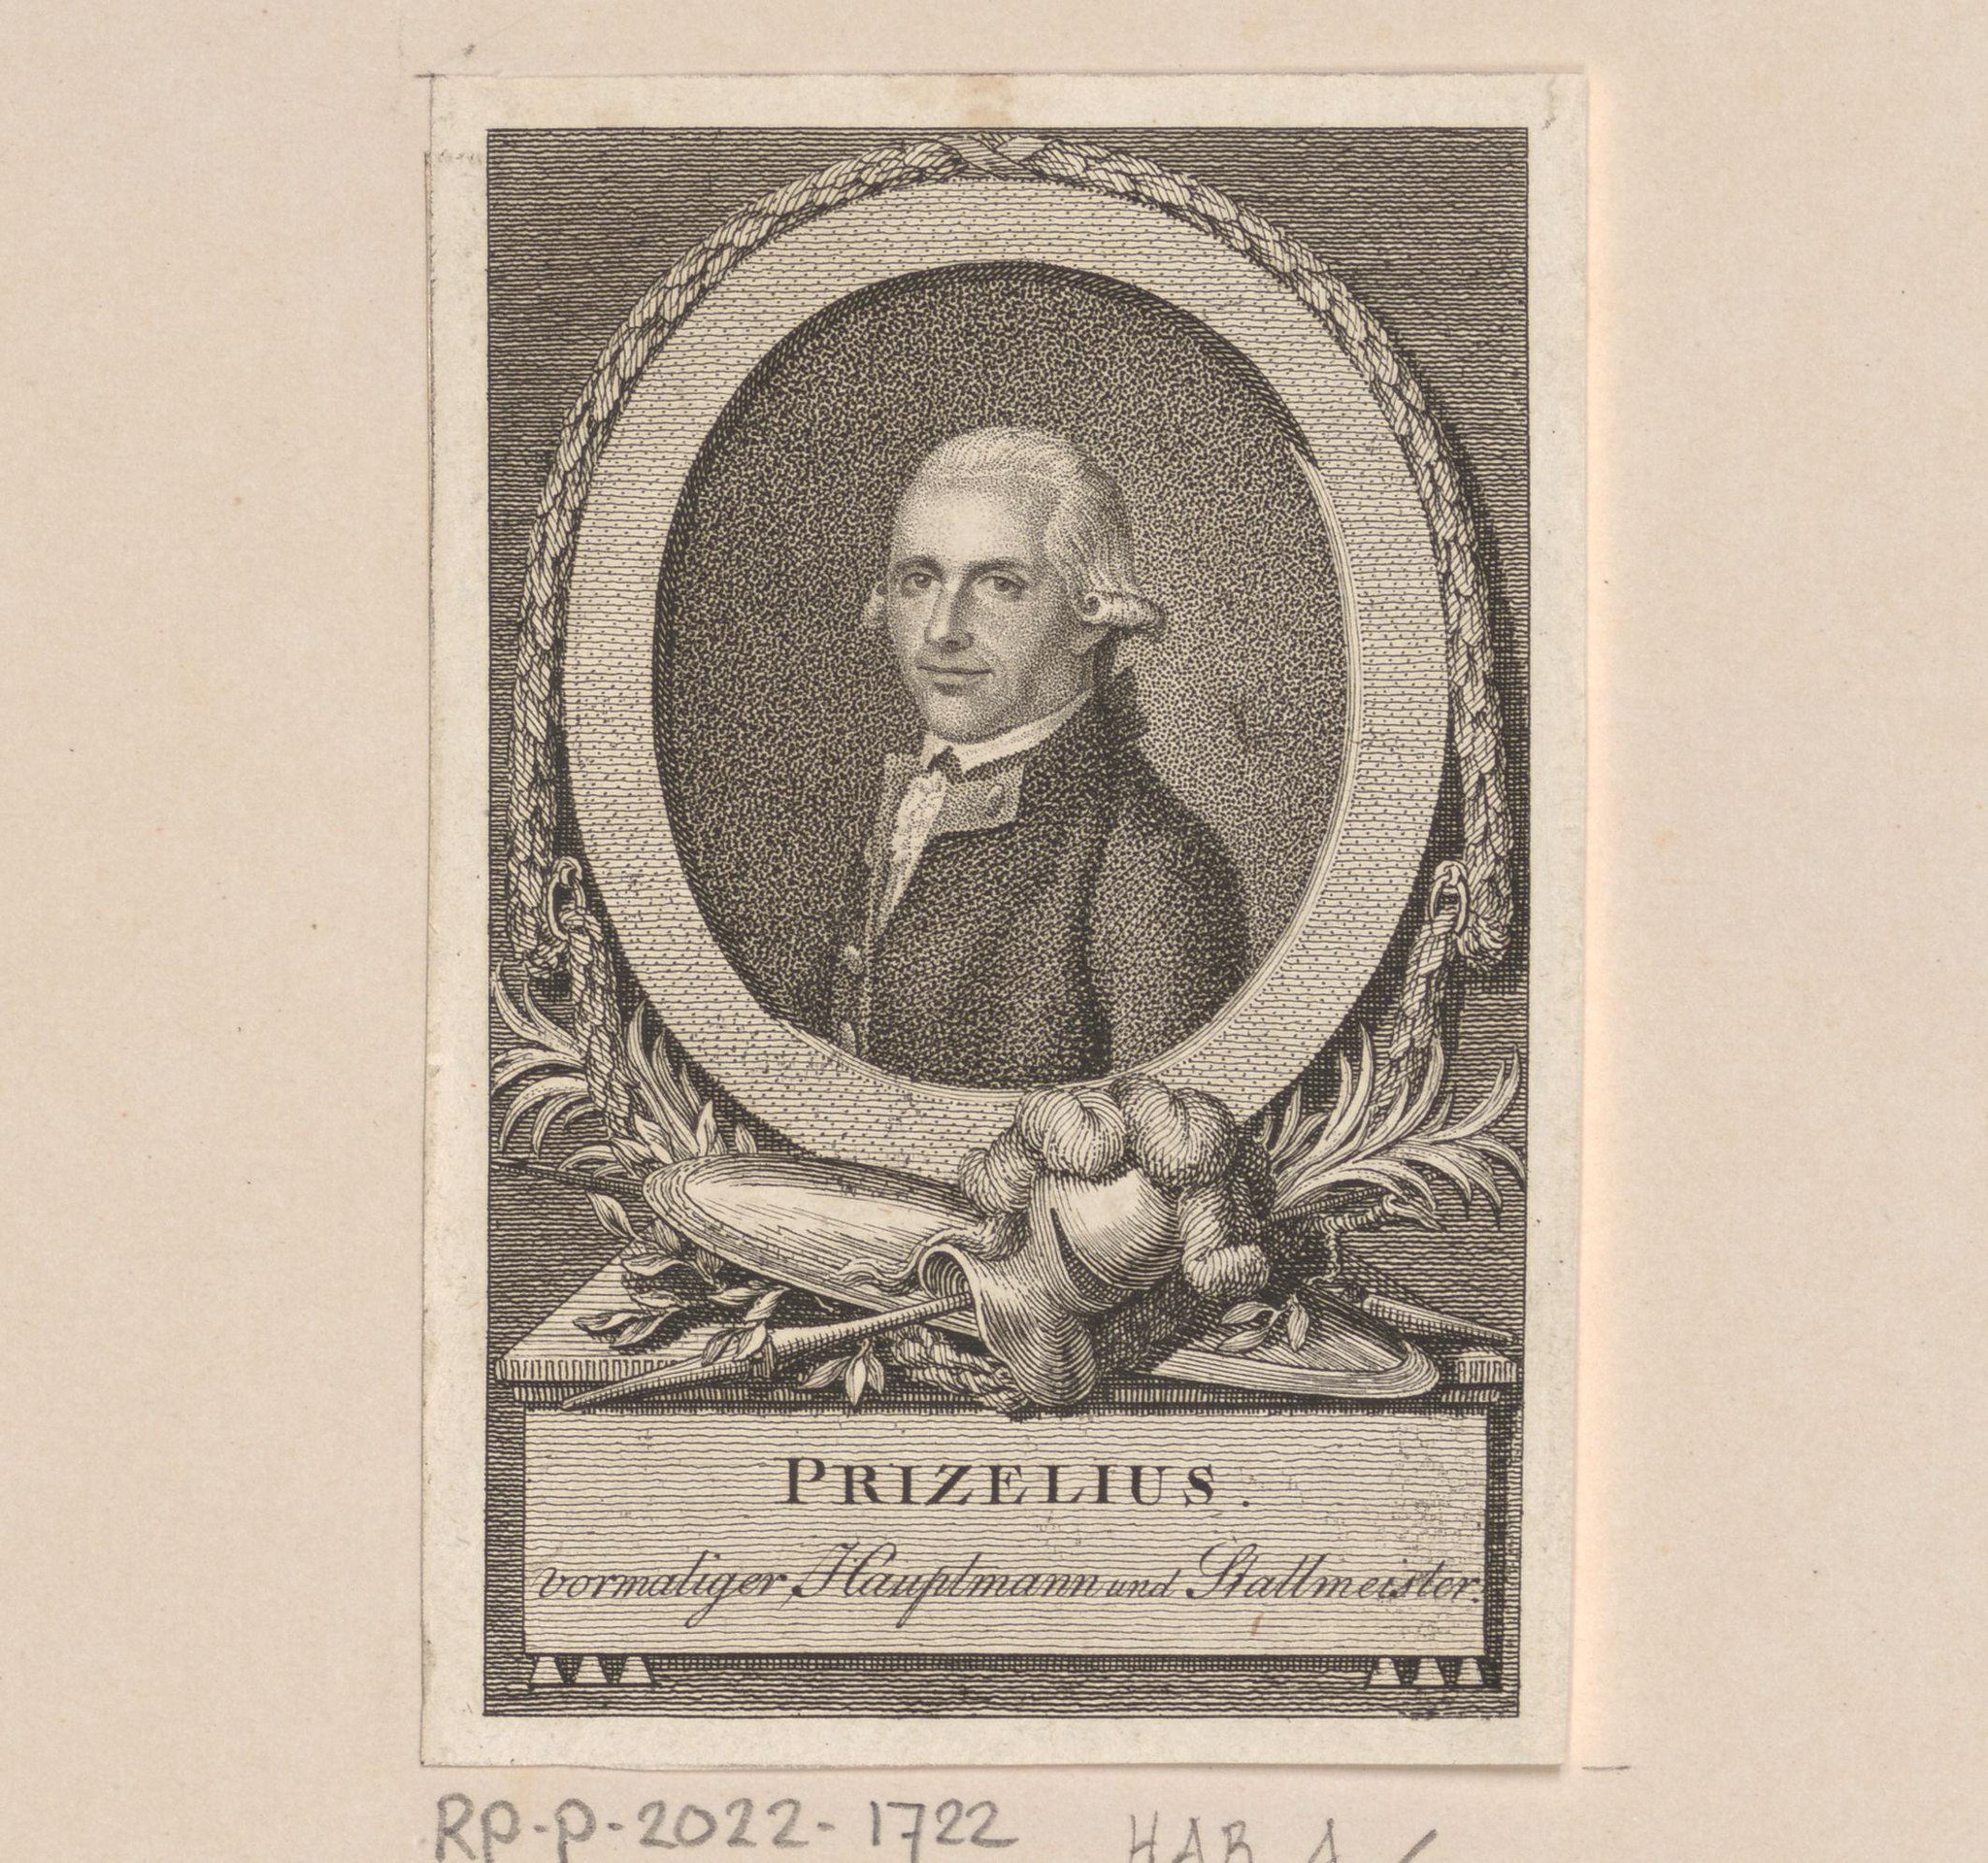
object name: print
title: Portret van Johann Gottfried Prizelius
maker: Anonymous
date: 1766-1799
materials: paper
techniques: etching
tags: historical persons, wig, military clothing and other equipment (uniforms, cap, armour, helmet, etc.)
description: Met eenregelig onderschrift in het Duits.